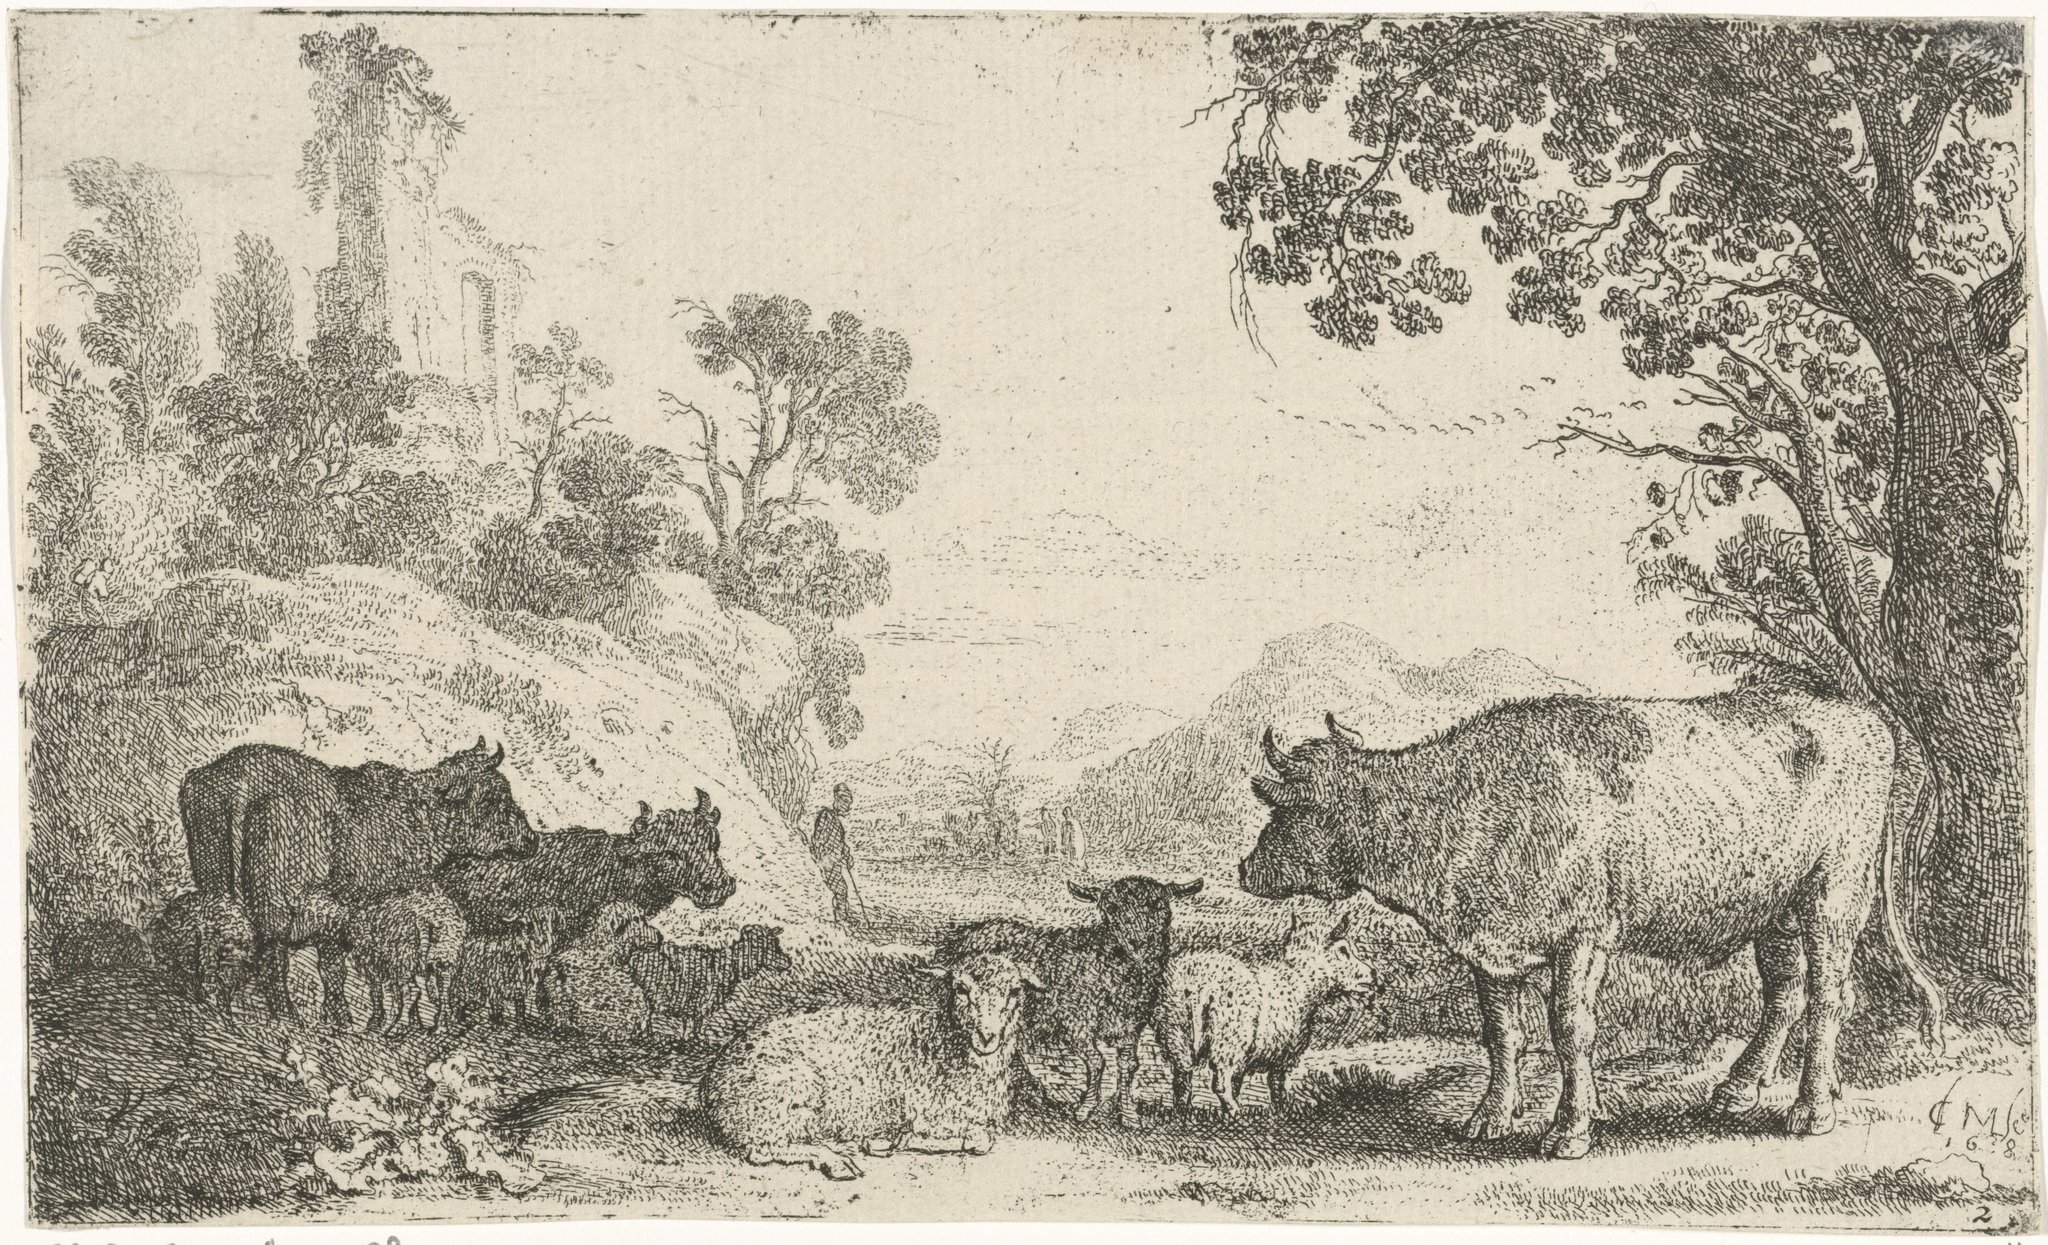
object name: print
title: Landschap met vee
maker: claes moeyaert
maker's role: draughtsman, painter, print maker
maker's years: 1592-1655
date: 1638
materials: paper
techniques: etching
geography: amsterdam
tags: cattle, landscape with ruins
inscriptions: collector's mark: Lugt 2228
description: Landschap met koeien en schapen op de voorgrond. Op de heuvel links een begroeide ruïne. Onderaan de berg een herder.